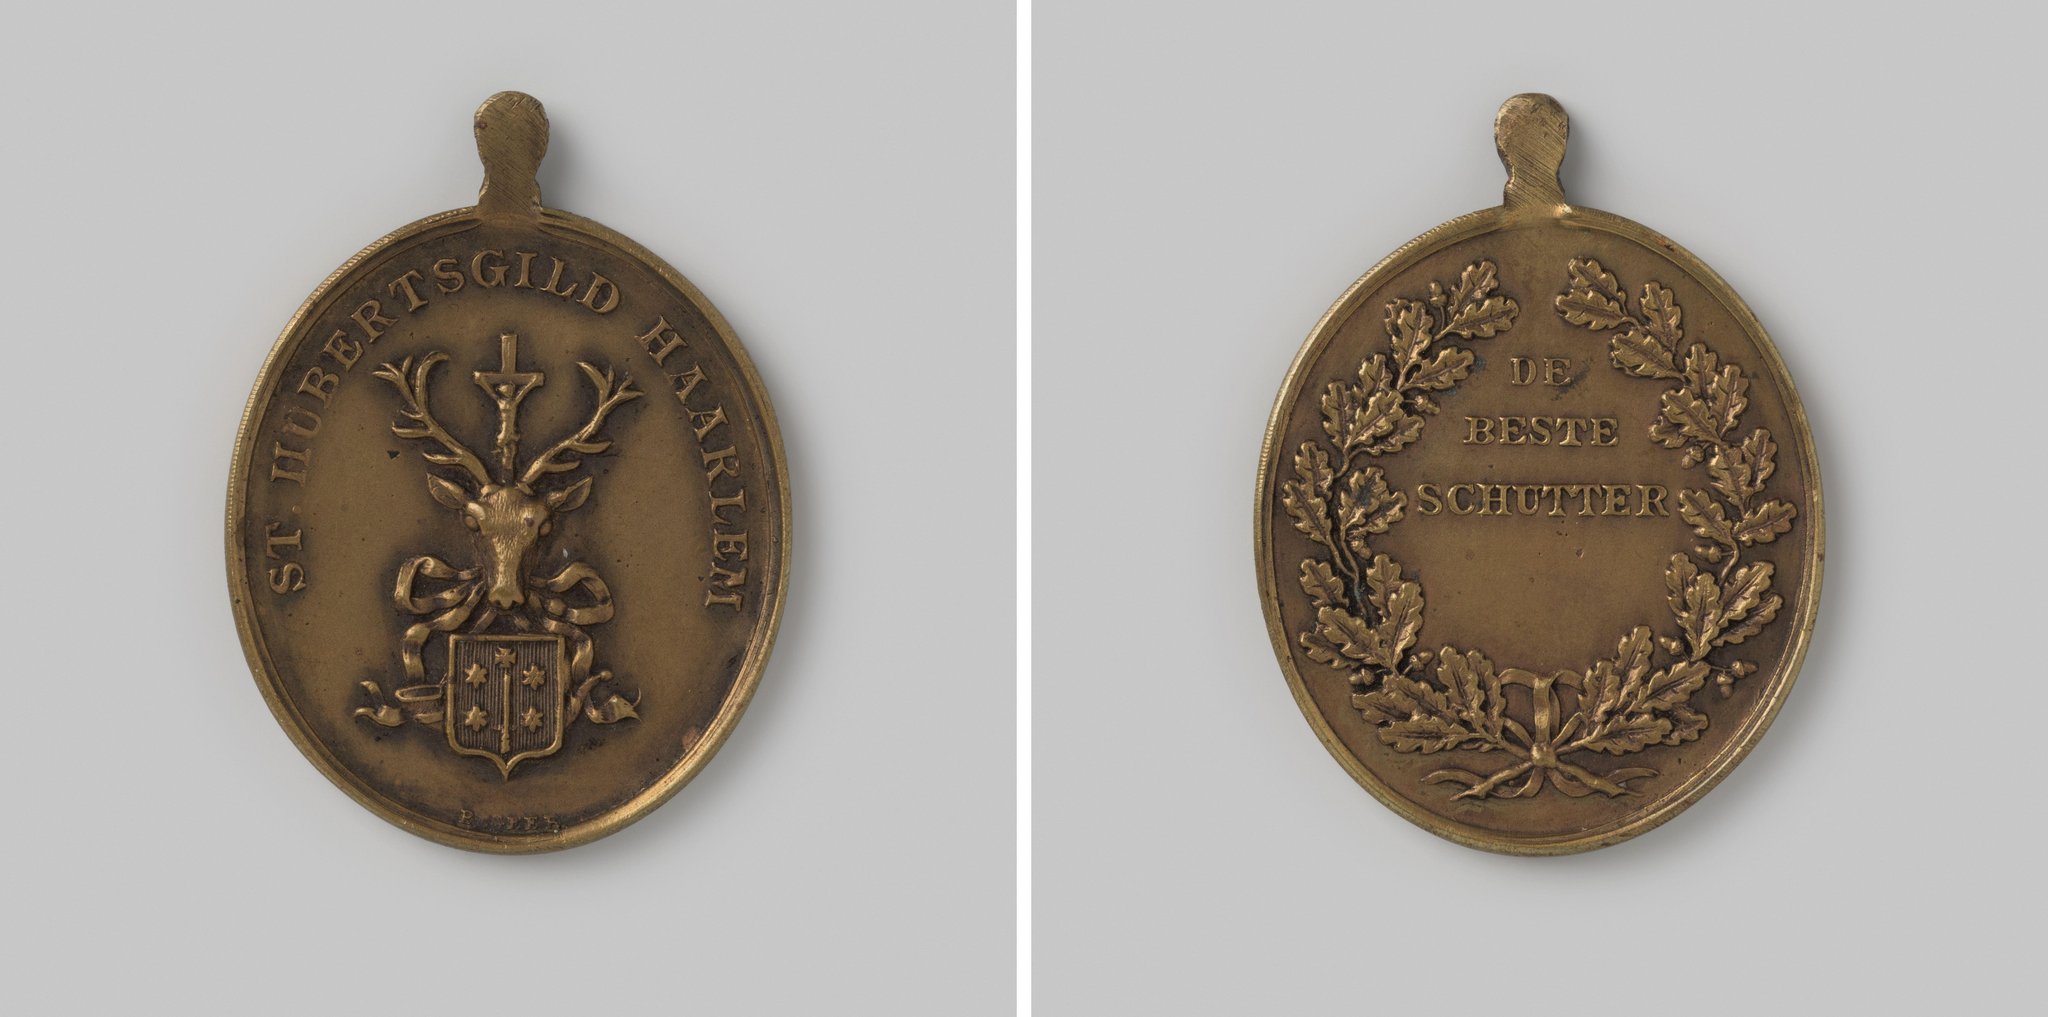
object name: history medal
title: Prijspenning van het Sint Hubertusgild te Haarlem (1890)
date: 1890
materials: brass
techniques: striking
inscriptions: inscription: ‘DE BESTE SCHUTTER’, circumscription: ‘ST. HUBERTSGILD HAARLEM’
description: Ovalen messing penning met niet-doorboord draagoog, op de voorzijde een hertenkop, met crucifix tussen de hoorns, het Haarlems wapenschild aan een lint in de bek, met omschrift, op de keerzijde een inscriptieruimte met drie regels tekst tussen samengestrikte eikentakken.